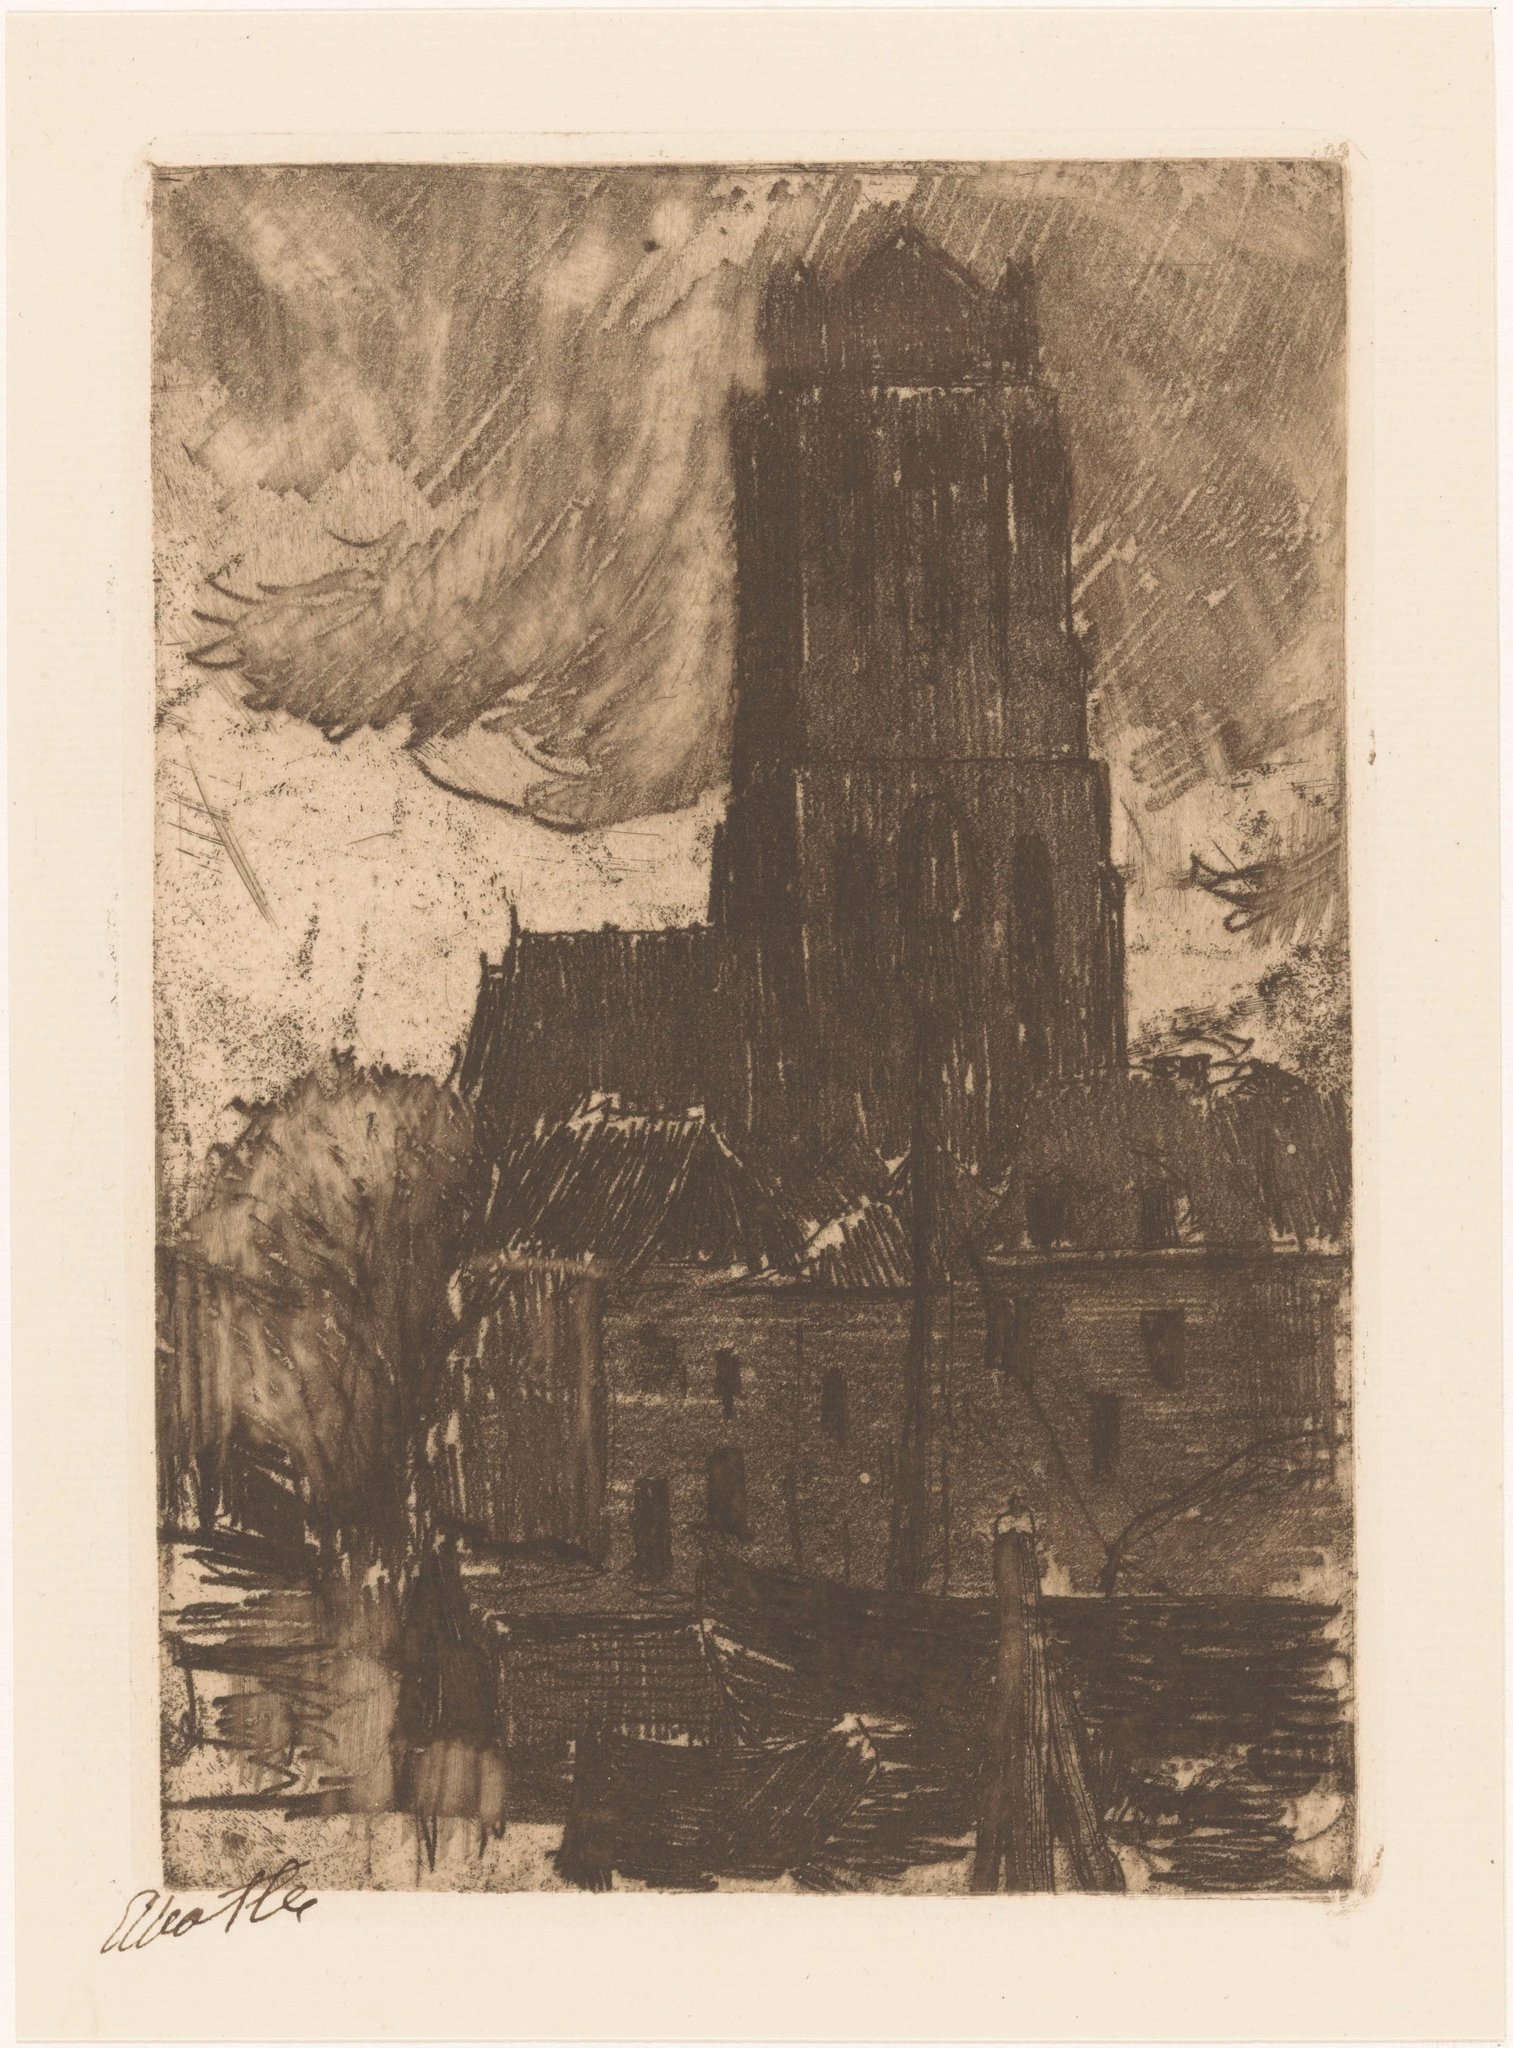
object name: print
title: Grote of Onze-Lieve-Vrouwekerk in Dordrecht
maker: etha fles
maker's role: print maker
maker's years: 1857-1948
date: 1867-1910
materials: paper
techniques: drypoint, soft ground etching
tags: church (exterior), canals, waters (in city)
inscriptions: collector's mark: Lugt 2228